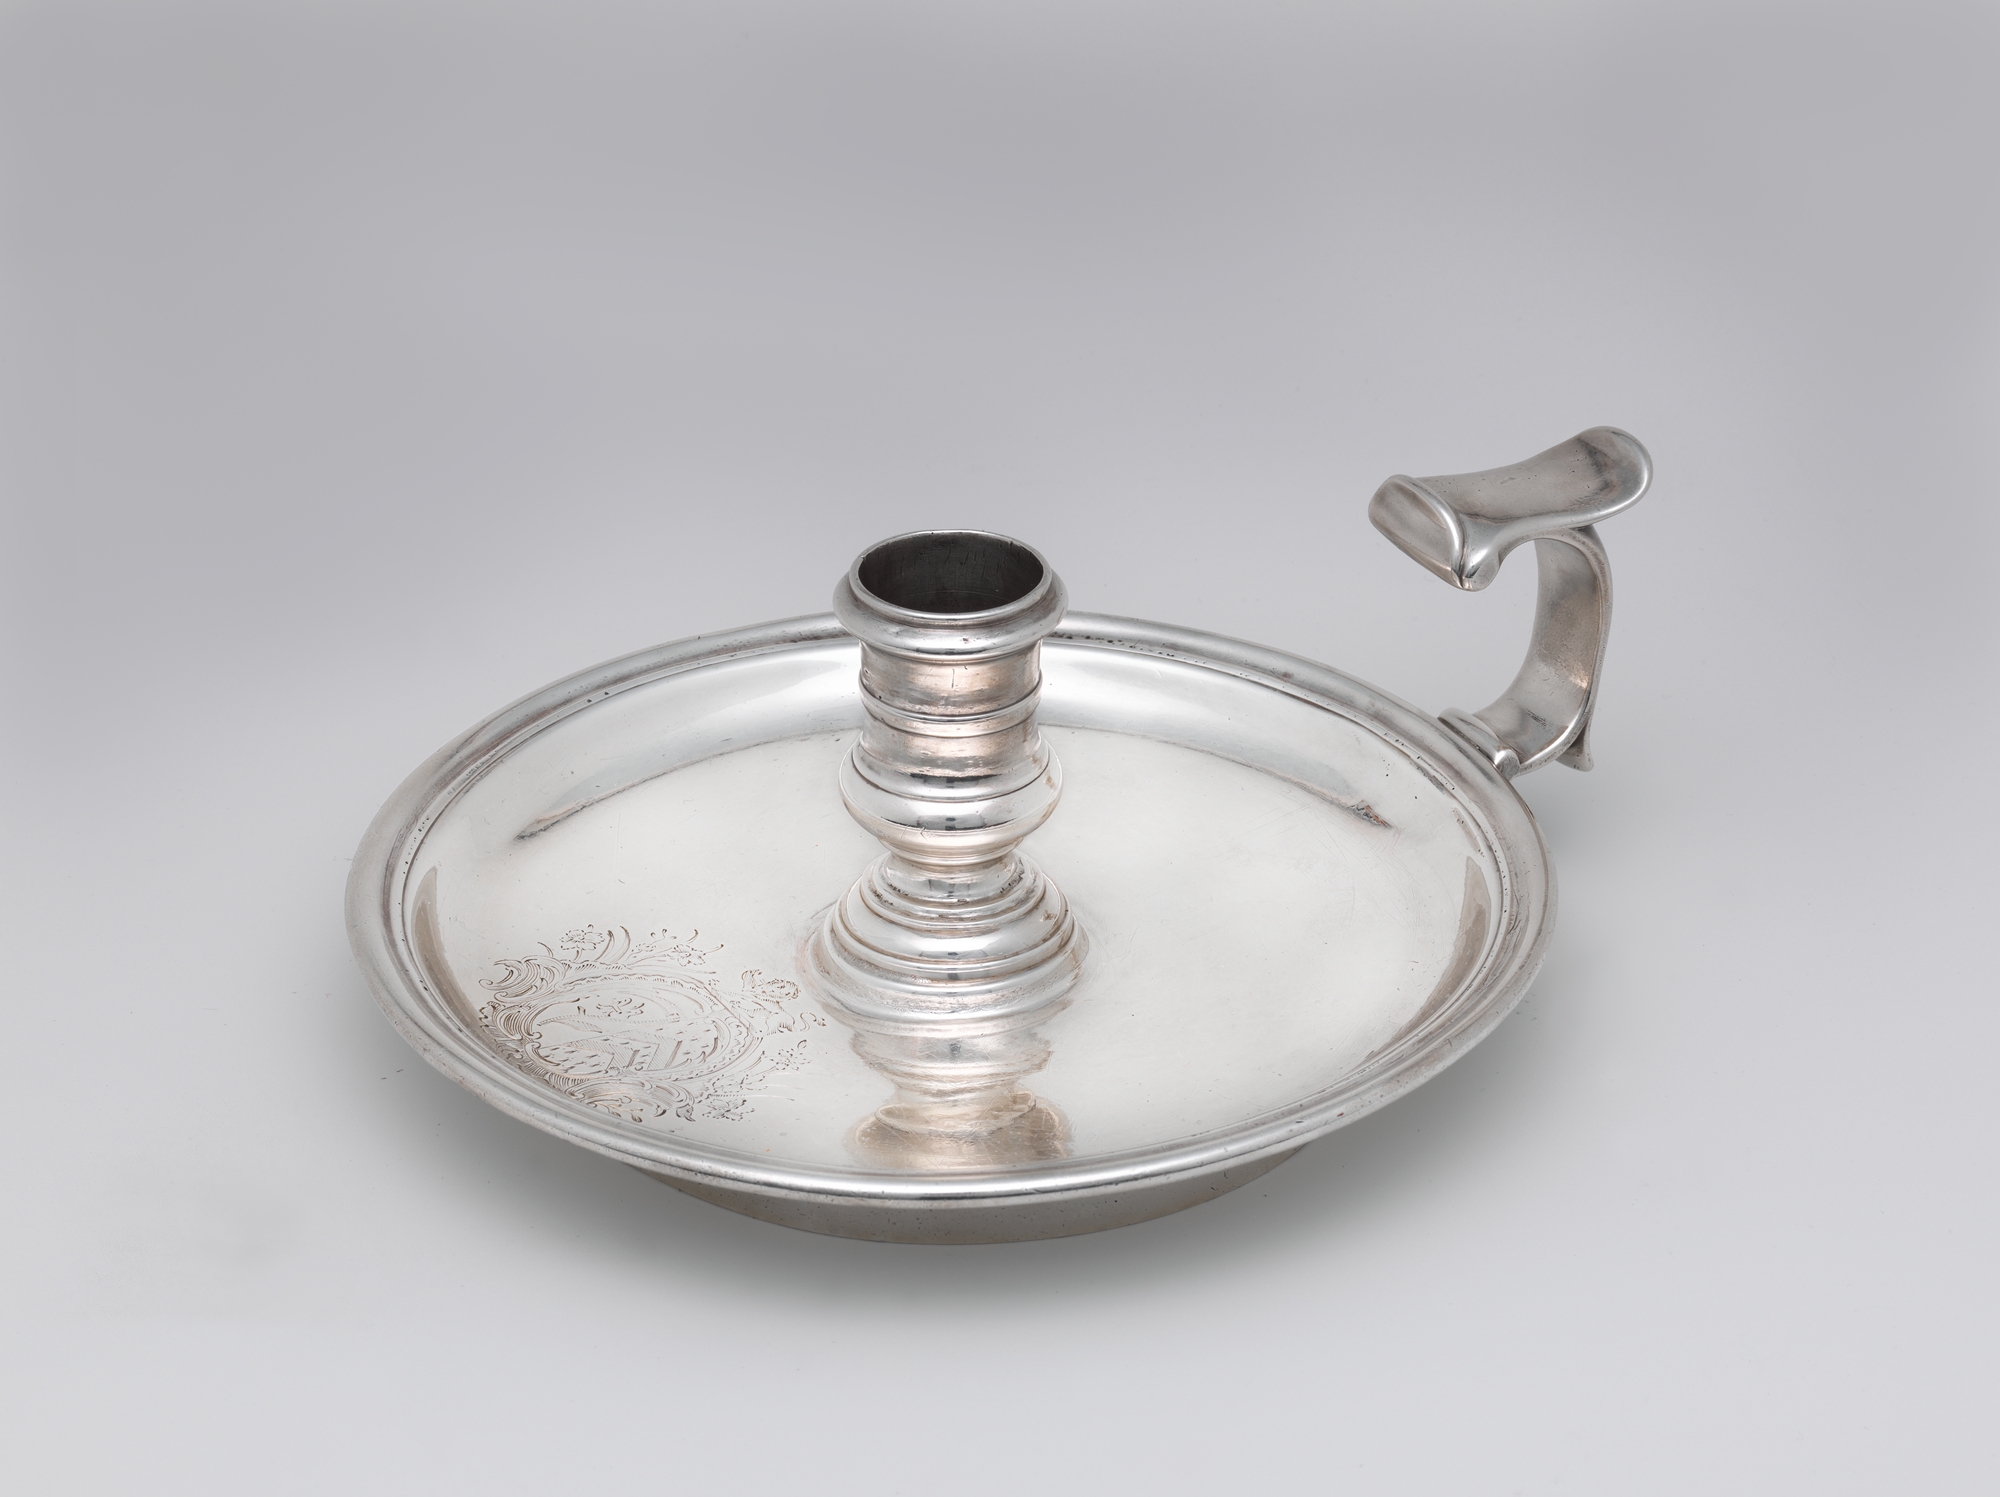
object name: chamber candlestick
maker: george wickes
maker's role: maker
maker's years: 1698-1761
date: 1743-1744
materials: silver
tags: lions,coat of arms